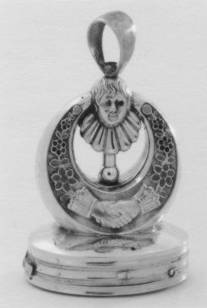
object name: music box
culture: swiss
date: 1840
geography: switzerland